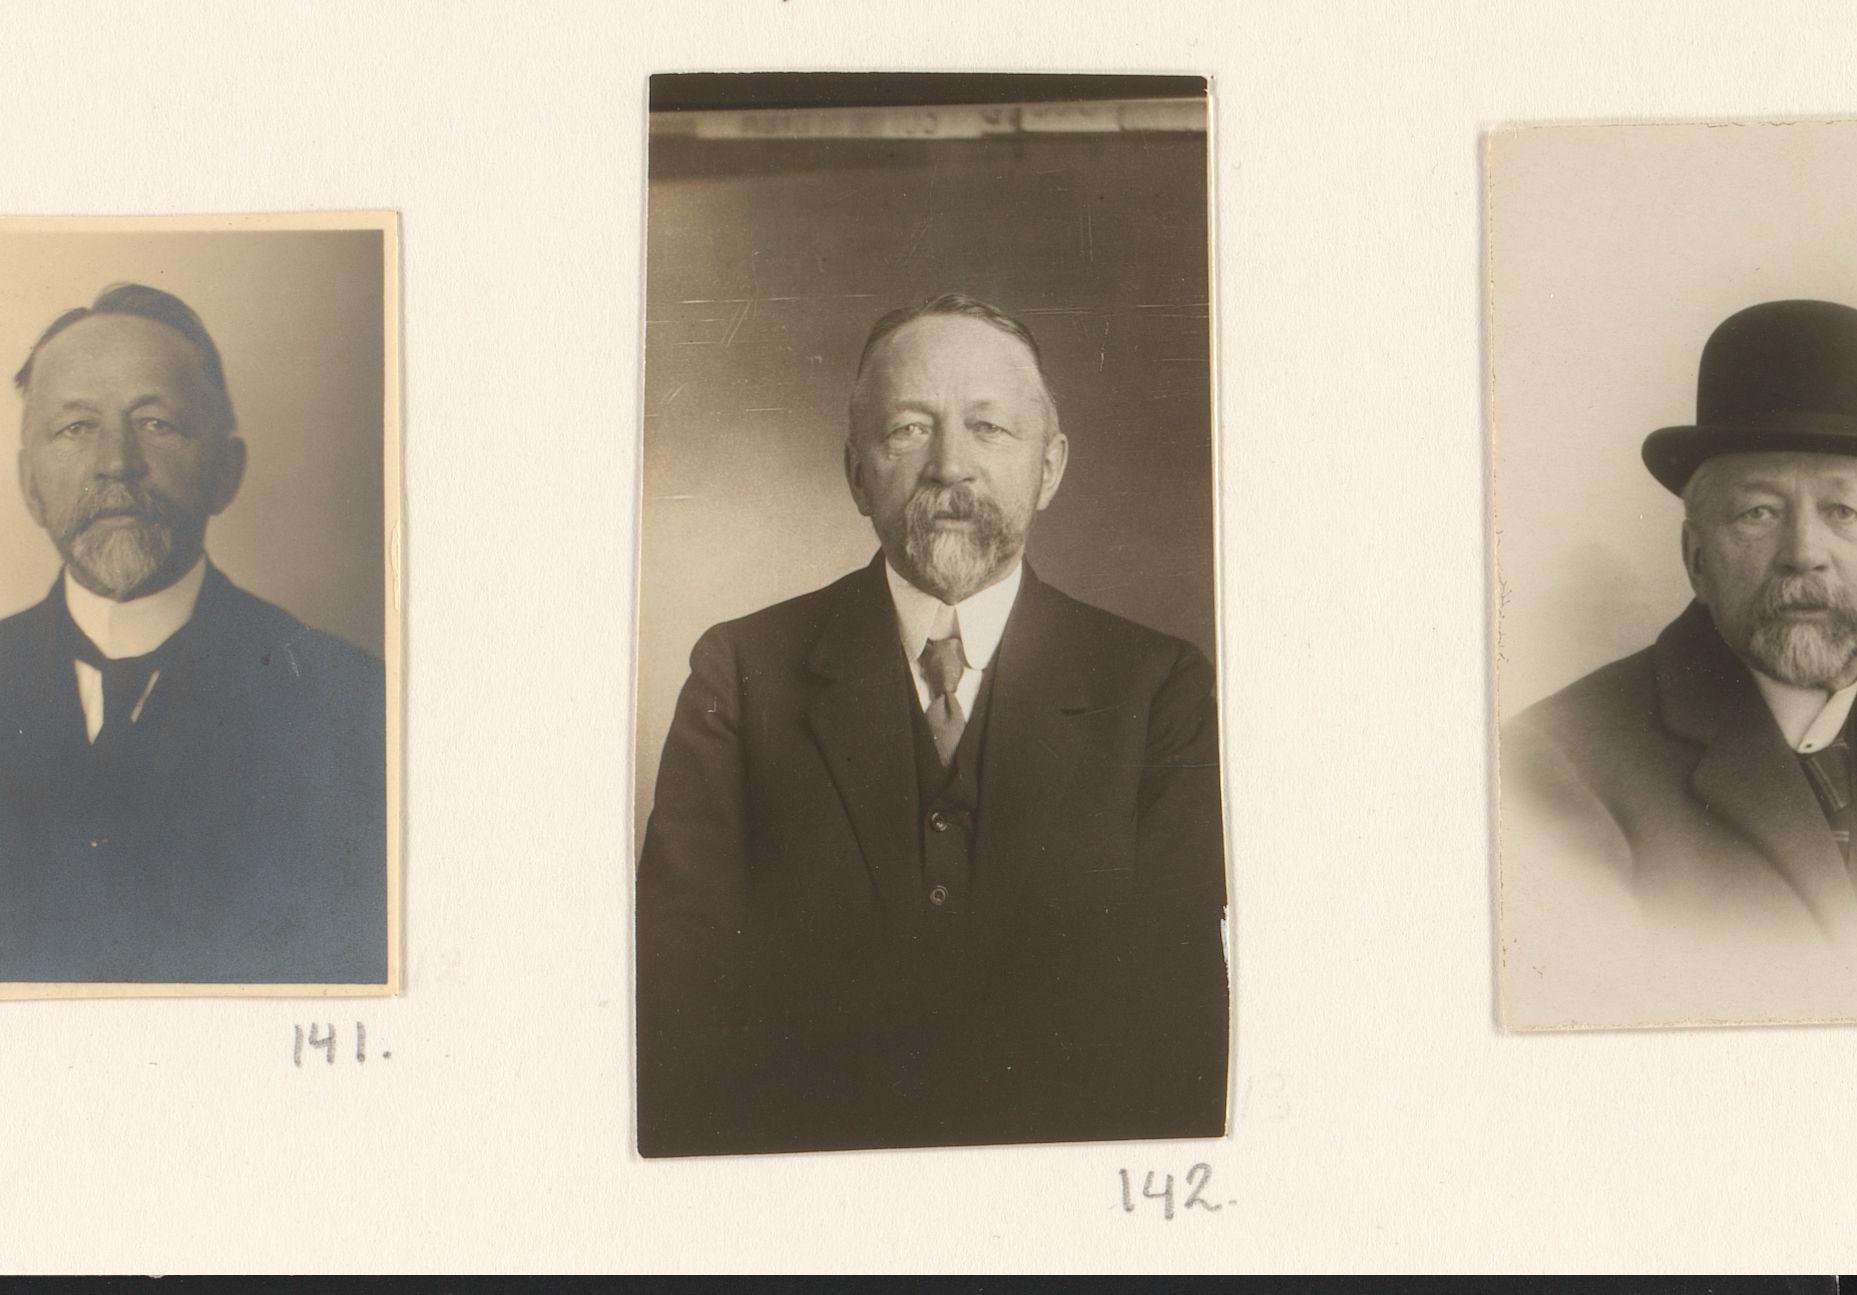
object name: photograph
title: Andries Bonger op middelbare leeftijd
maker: Anonymous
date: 1930-1936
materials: cardboard, paper, photographic support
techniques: gelatin silver print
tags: amsterdam, andries bonger, historical persons